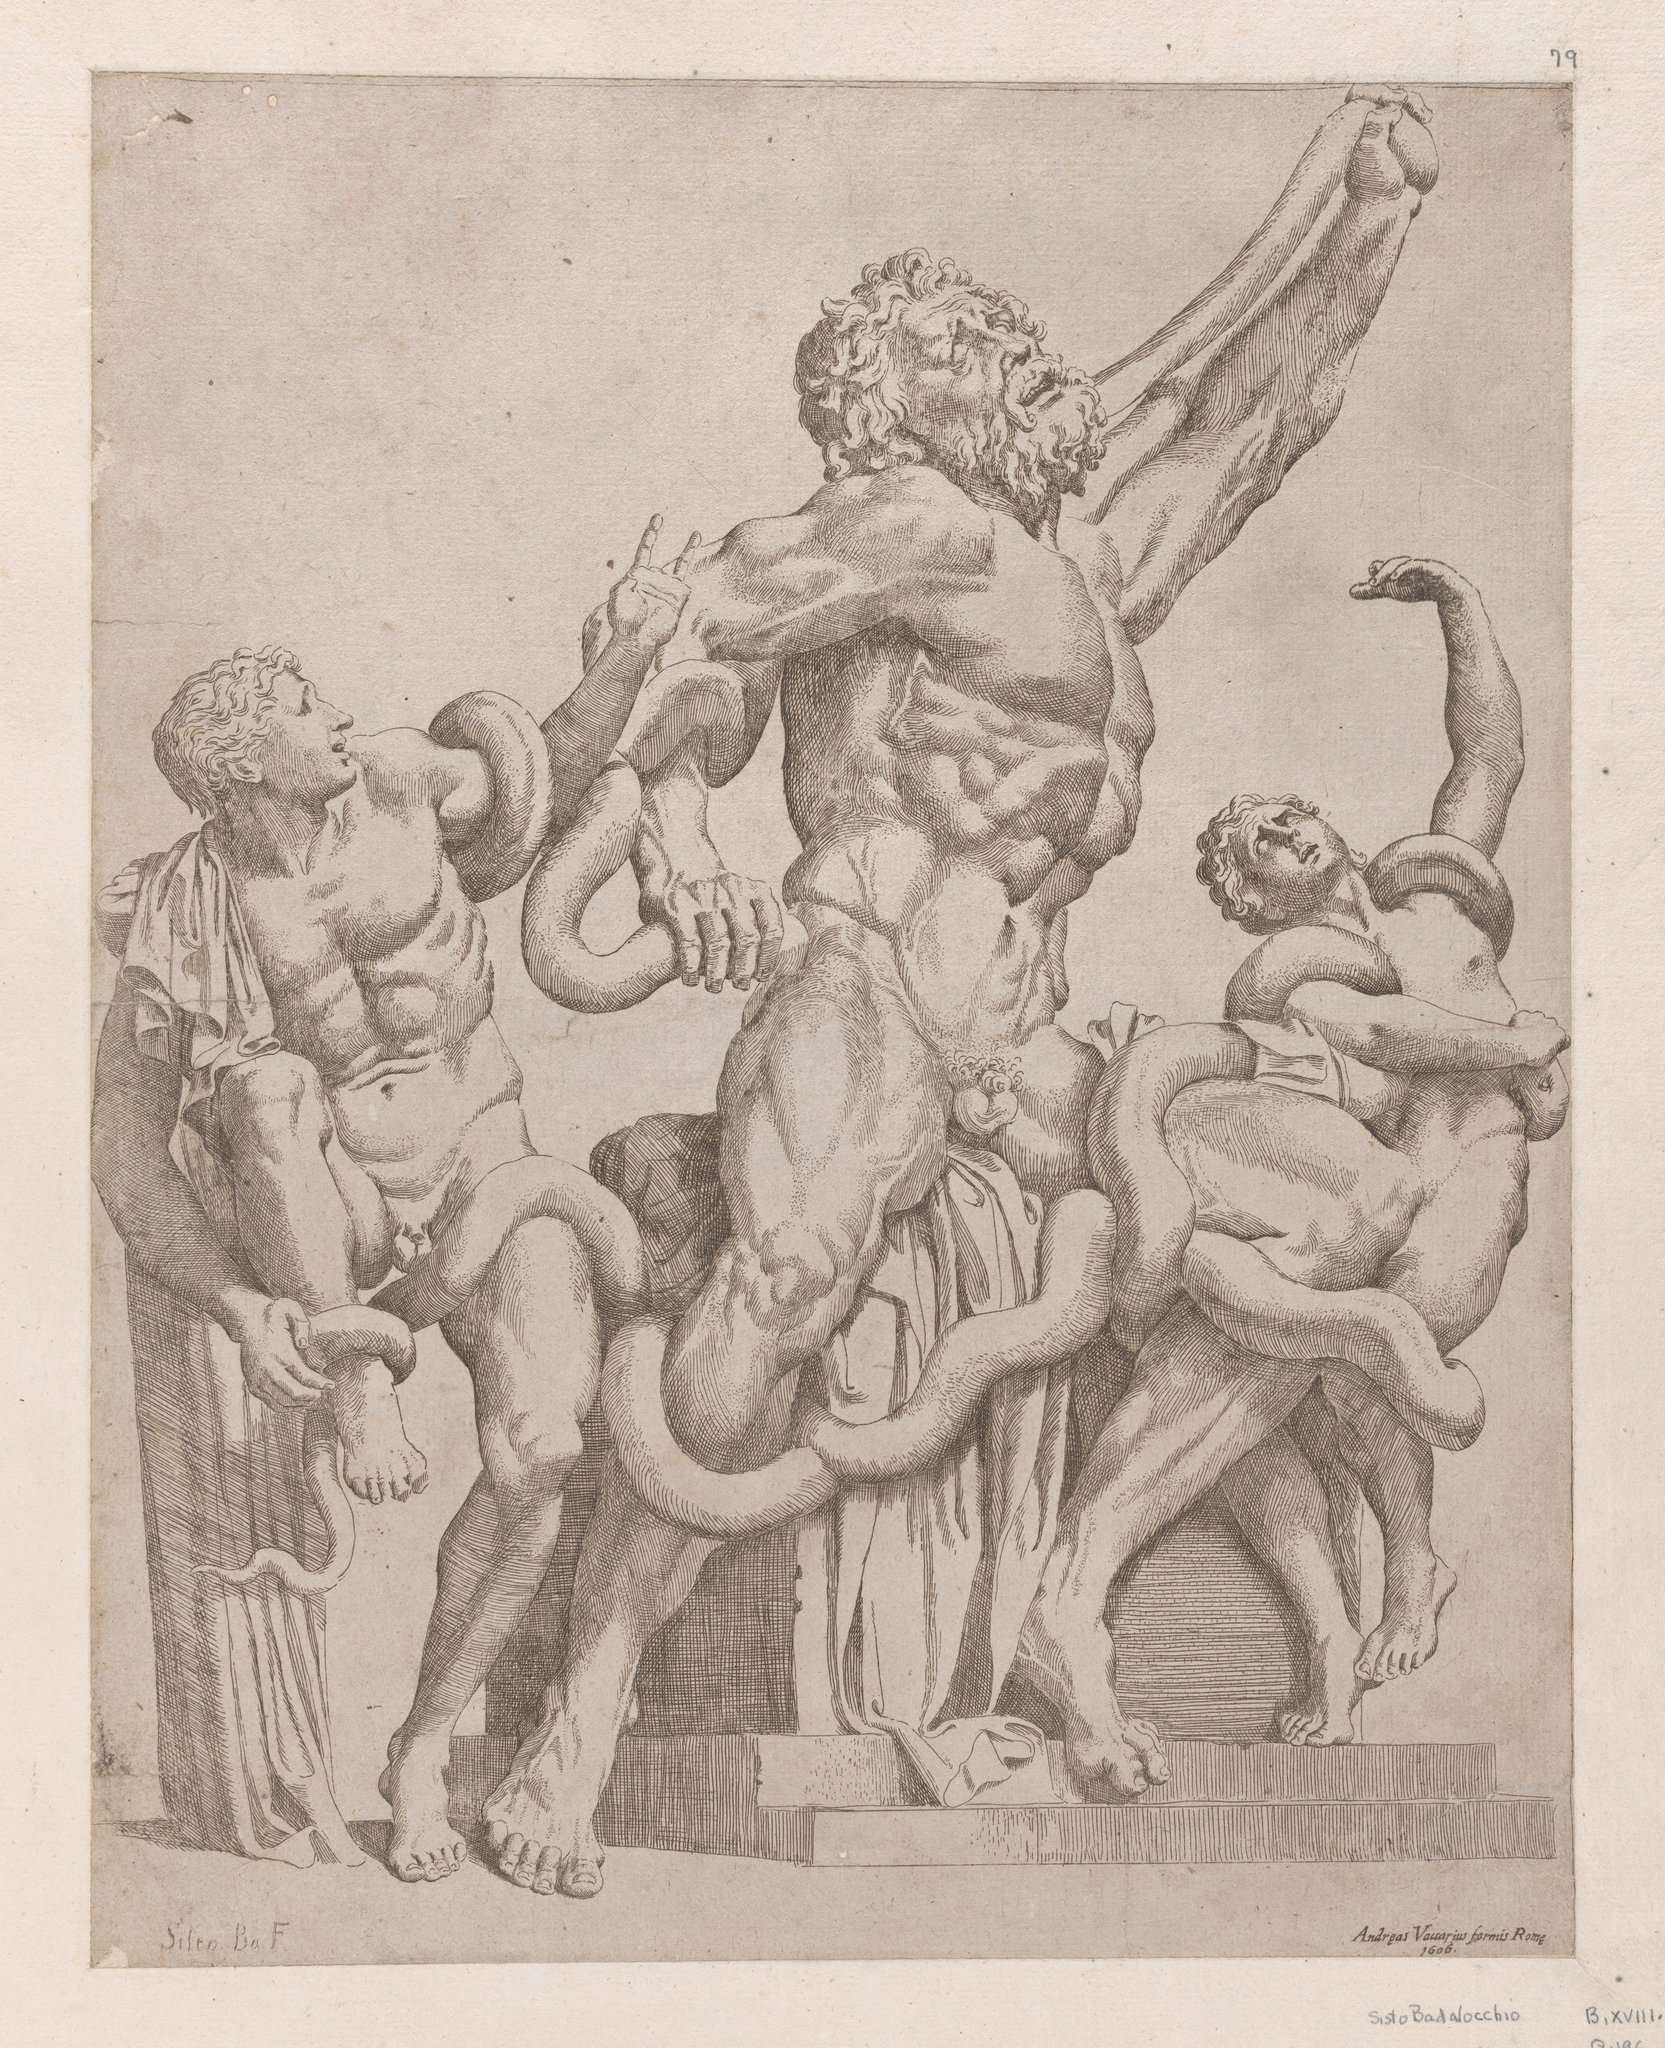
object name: print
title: Laocoon, from "Speculum Romanae Magnificentiae"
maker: sisto badalocchio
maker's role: artist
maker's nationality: italian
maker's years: 1585-1619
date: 1561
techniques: etching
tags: male nudes